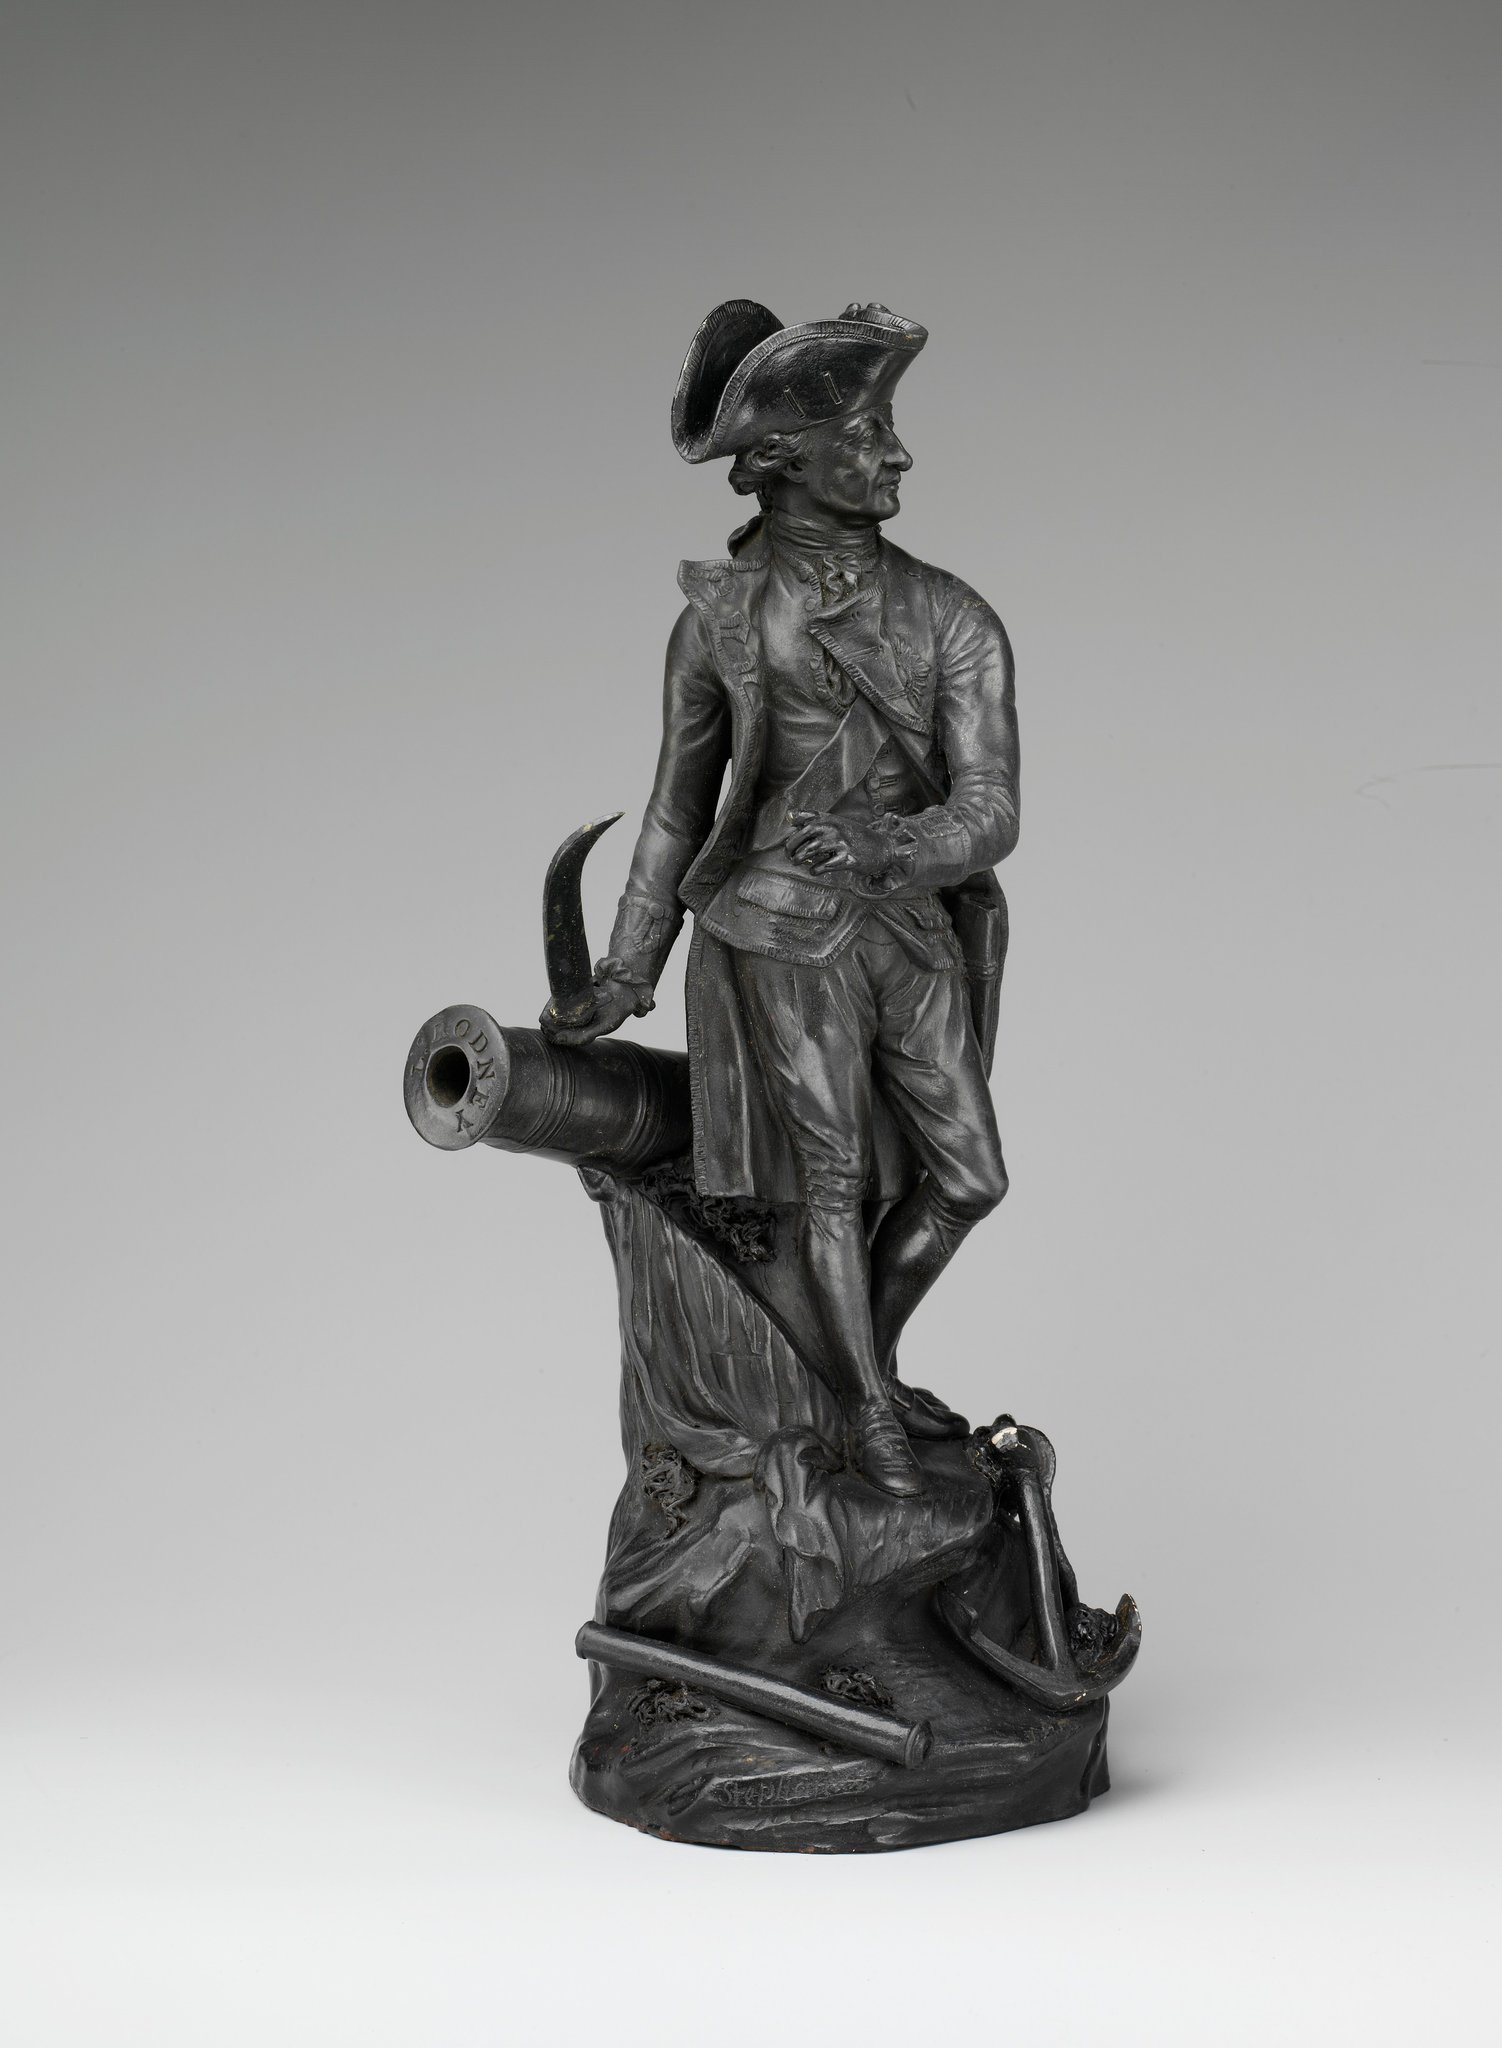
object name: figure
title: Figure of Admiral George Rodney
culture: british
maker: pierre stephan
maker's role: maker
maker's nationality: french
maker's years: 1765-1795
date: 1785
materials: stone, earthenware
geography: england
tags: cannons,swords,men